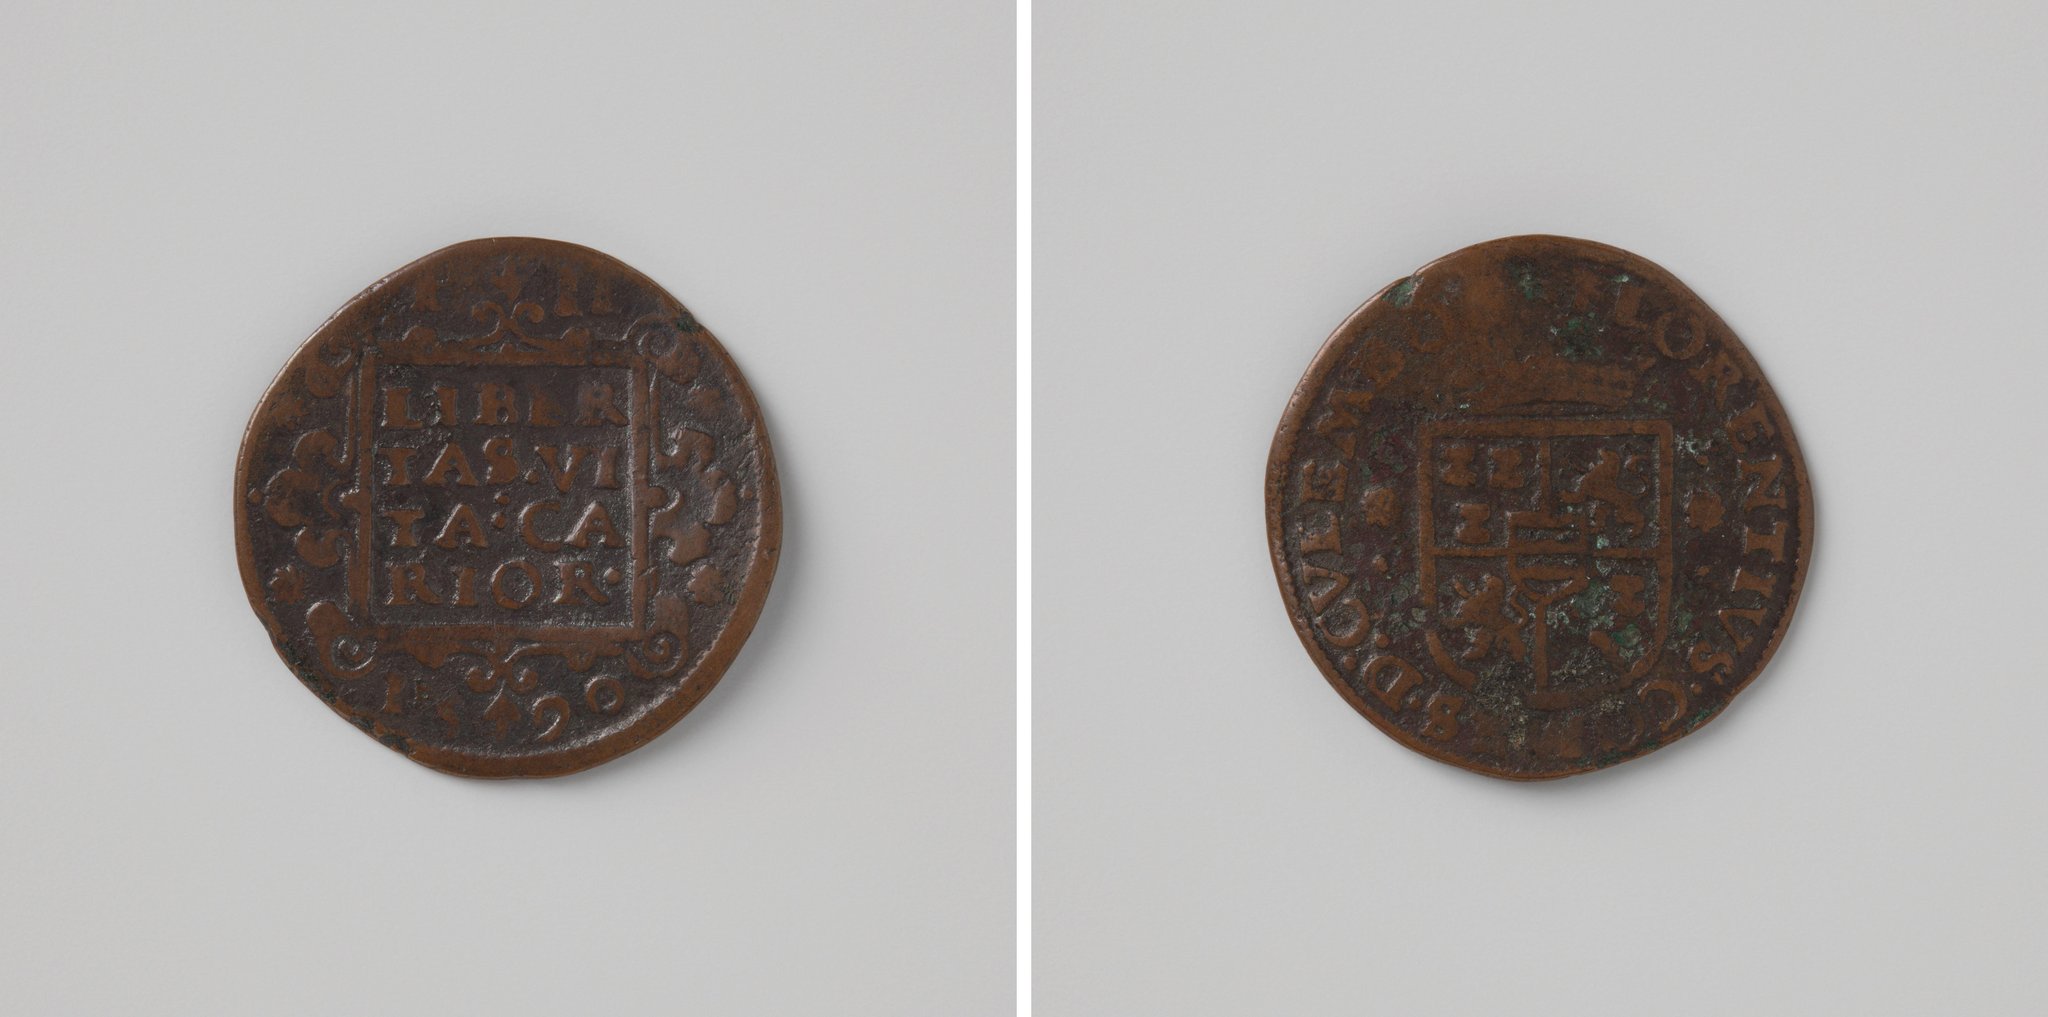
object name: coin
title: Floris I van Pallandt, graaf van Culemborg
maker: Anonymous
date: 1590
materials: copper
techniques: striking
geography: culemborg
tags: earl, floris i van pallandt (graaf van culemborg)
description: Koperen munt. Voorzijde: vierkant tableau met opschrift in versierd cartouche onder waardeaanduiding, boven jaartal. Keerzijde: gekroond wapenschild tussen twee rozetten binnen omschrift. No. 3.